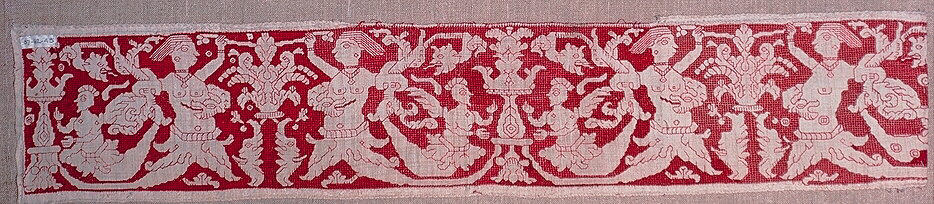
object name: strip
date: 1501-1600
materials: linen, silk